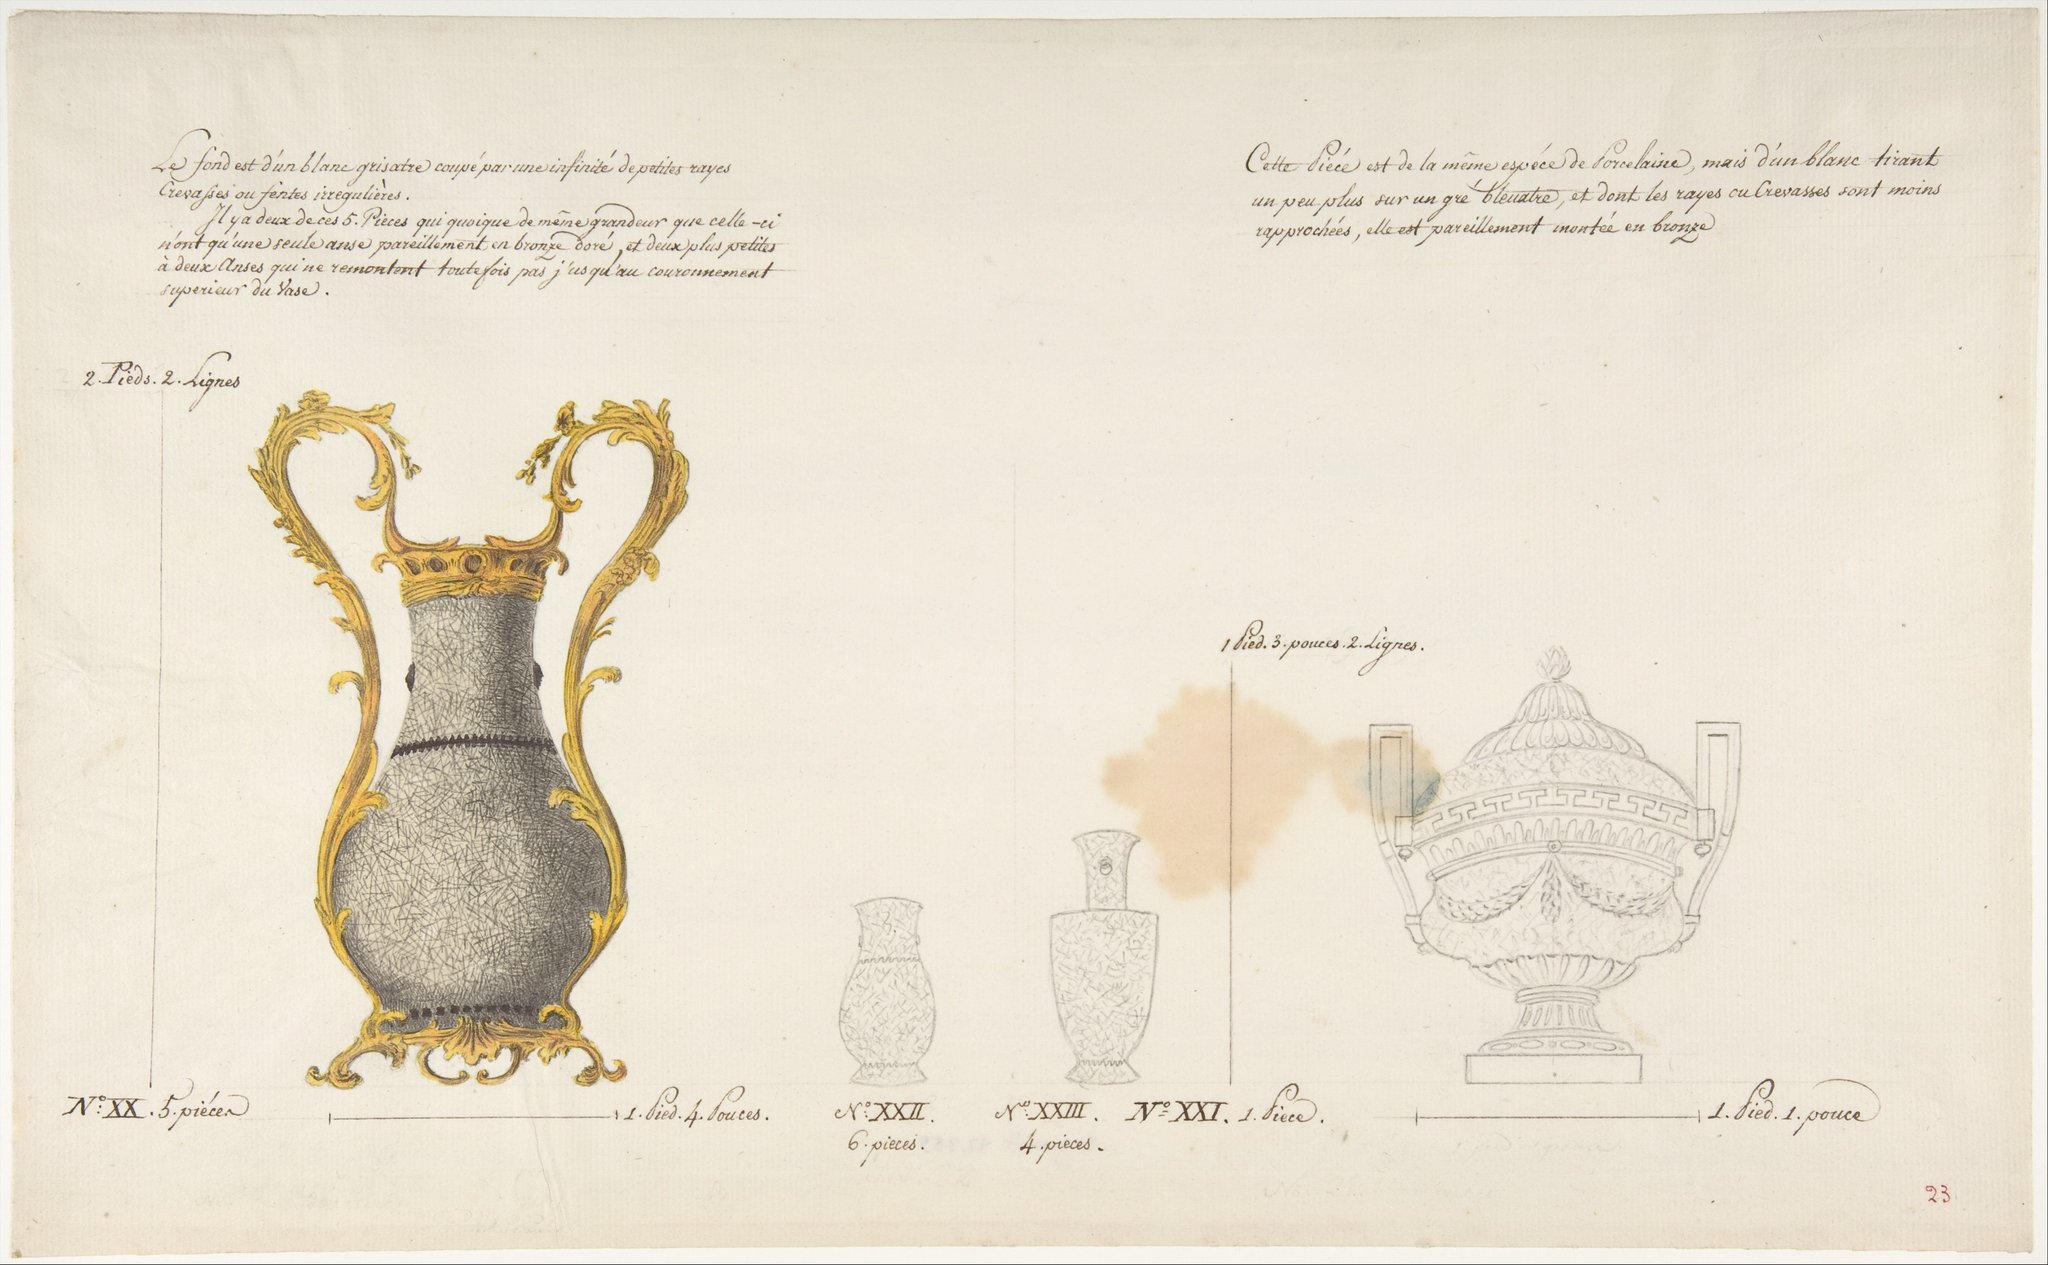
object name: drawing ornament architecture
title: Design for Four Vases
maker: anonymous, french, 18th century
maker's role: artist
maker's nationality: french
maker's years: 1700-1800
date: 1770-1785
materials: chalk, ink, watercolor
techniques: pen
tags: vases